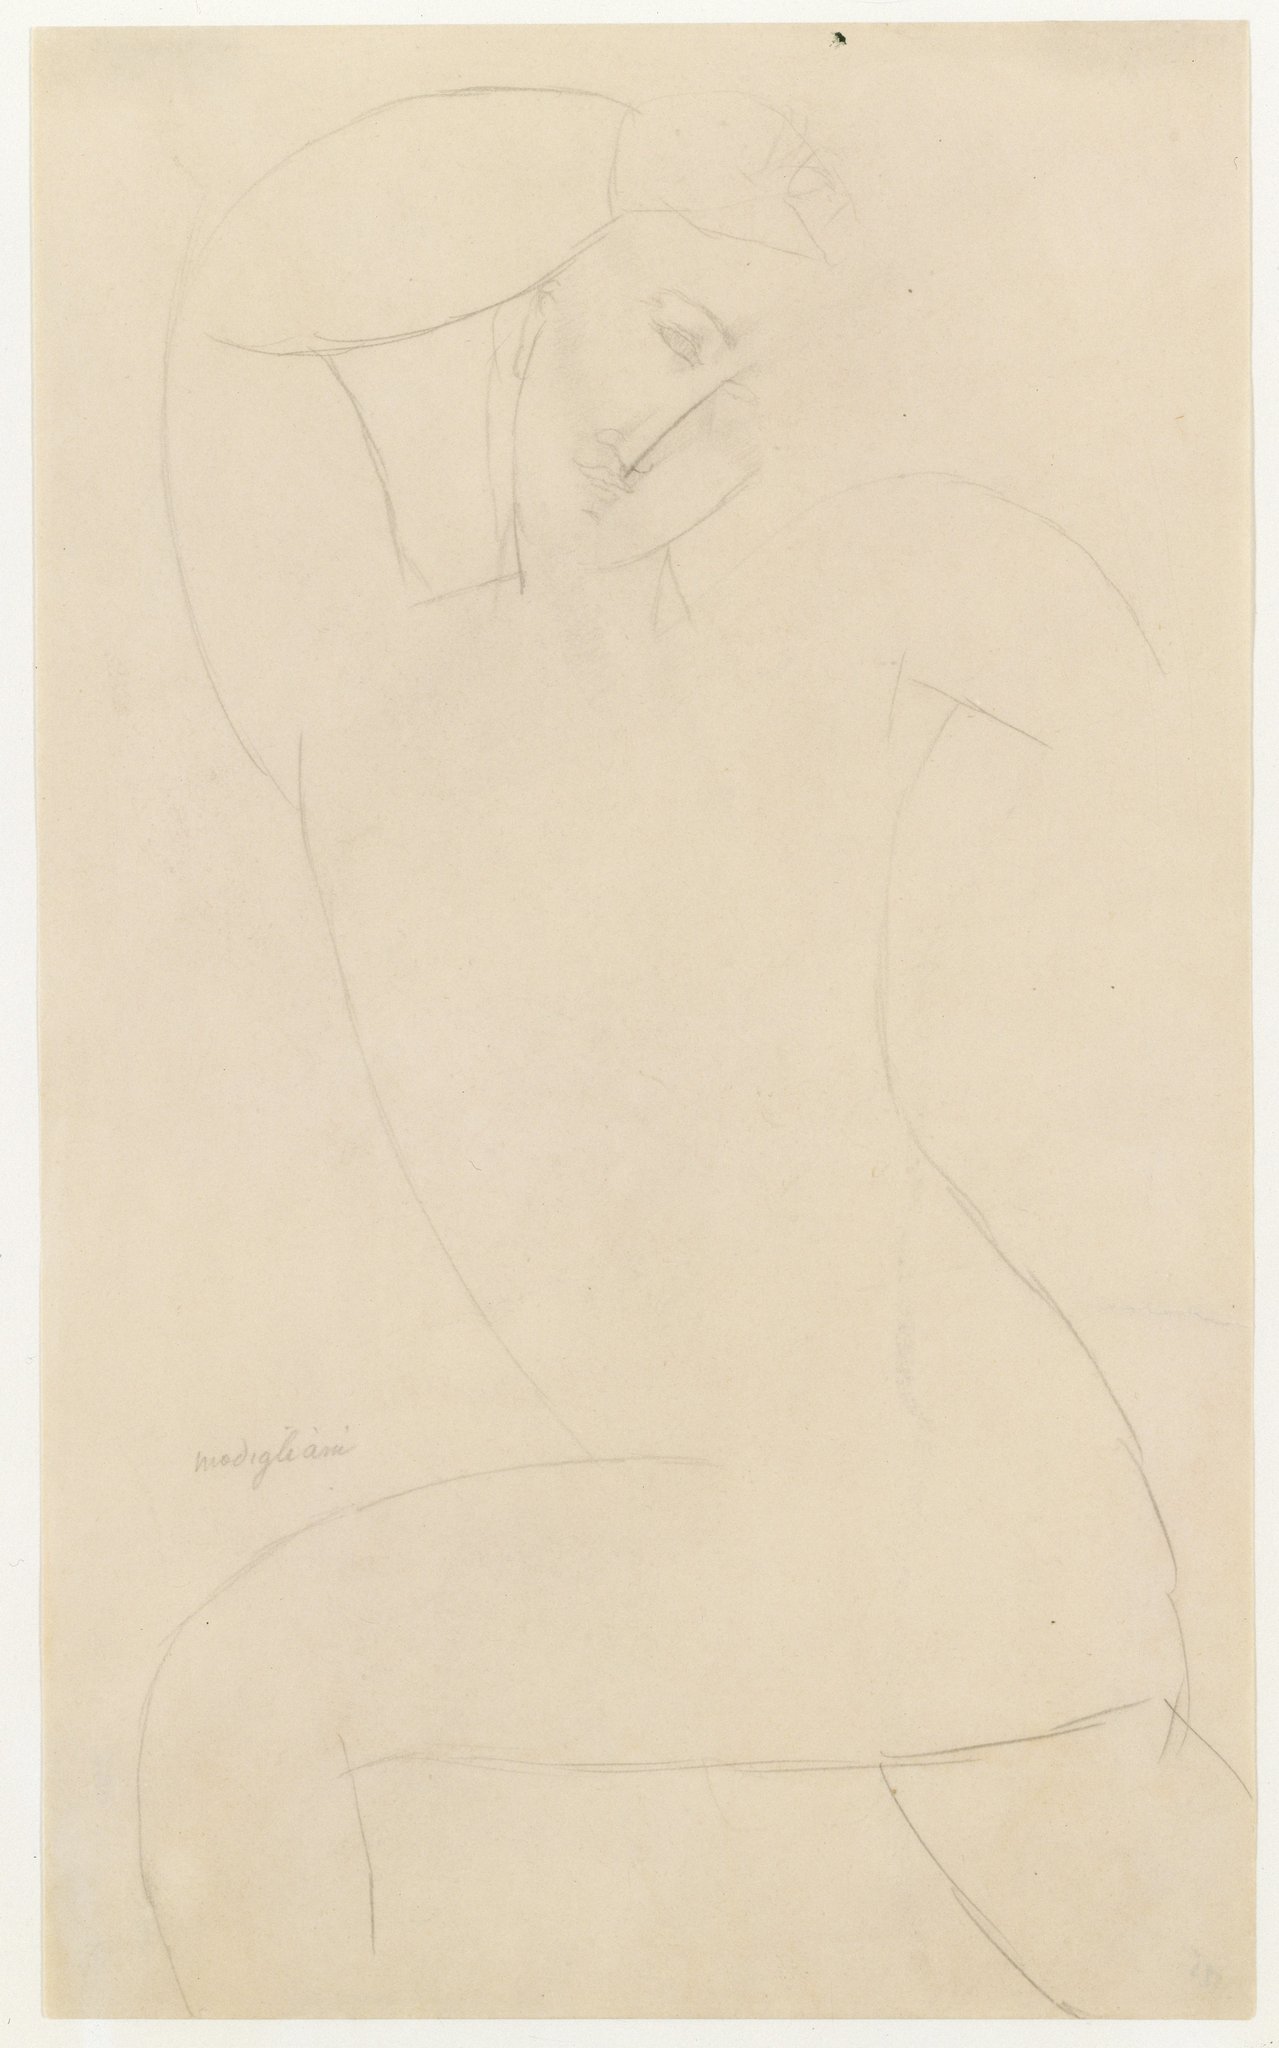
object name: drawing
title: Standing Nude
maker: amedeo modigliani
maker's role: artist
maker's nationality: italian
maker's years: 1884-1920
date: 1910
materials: graphite, paper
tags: male nudes